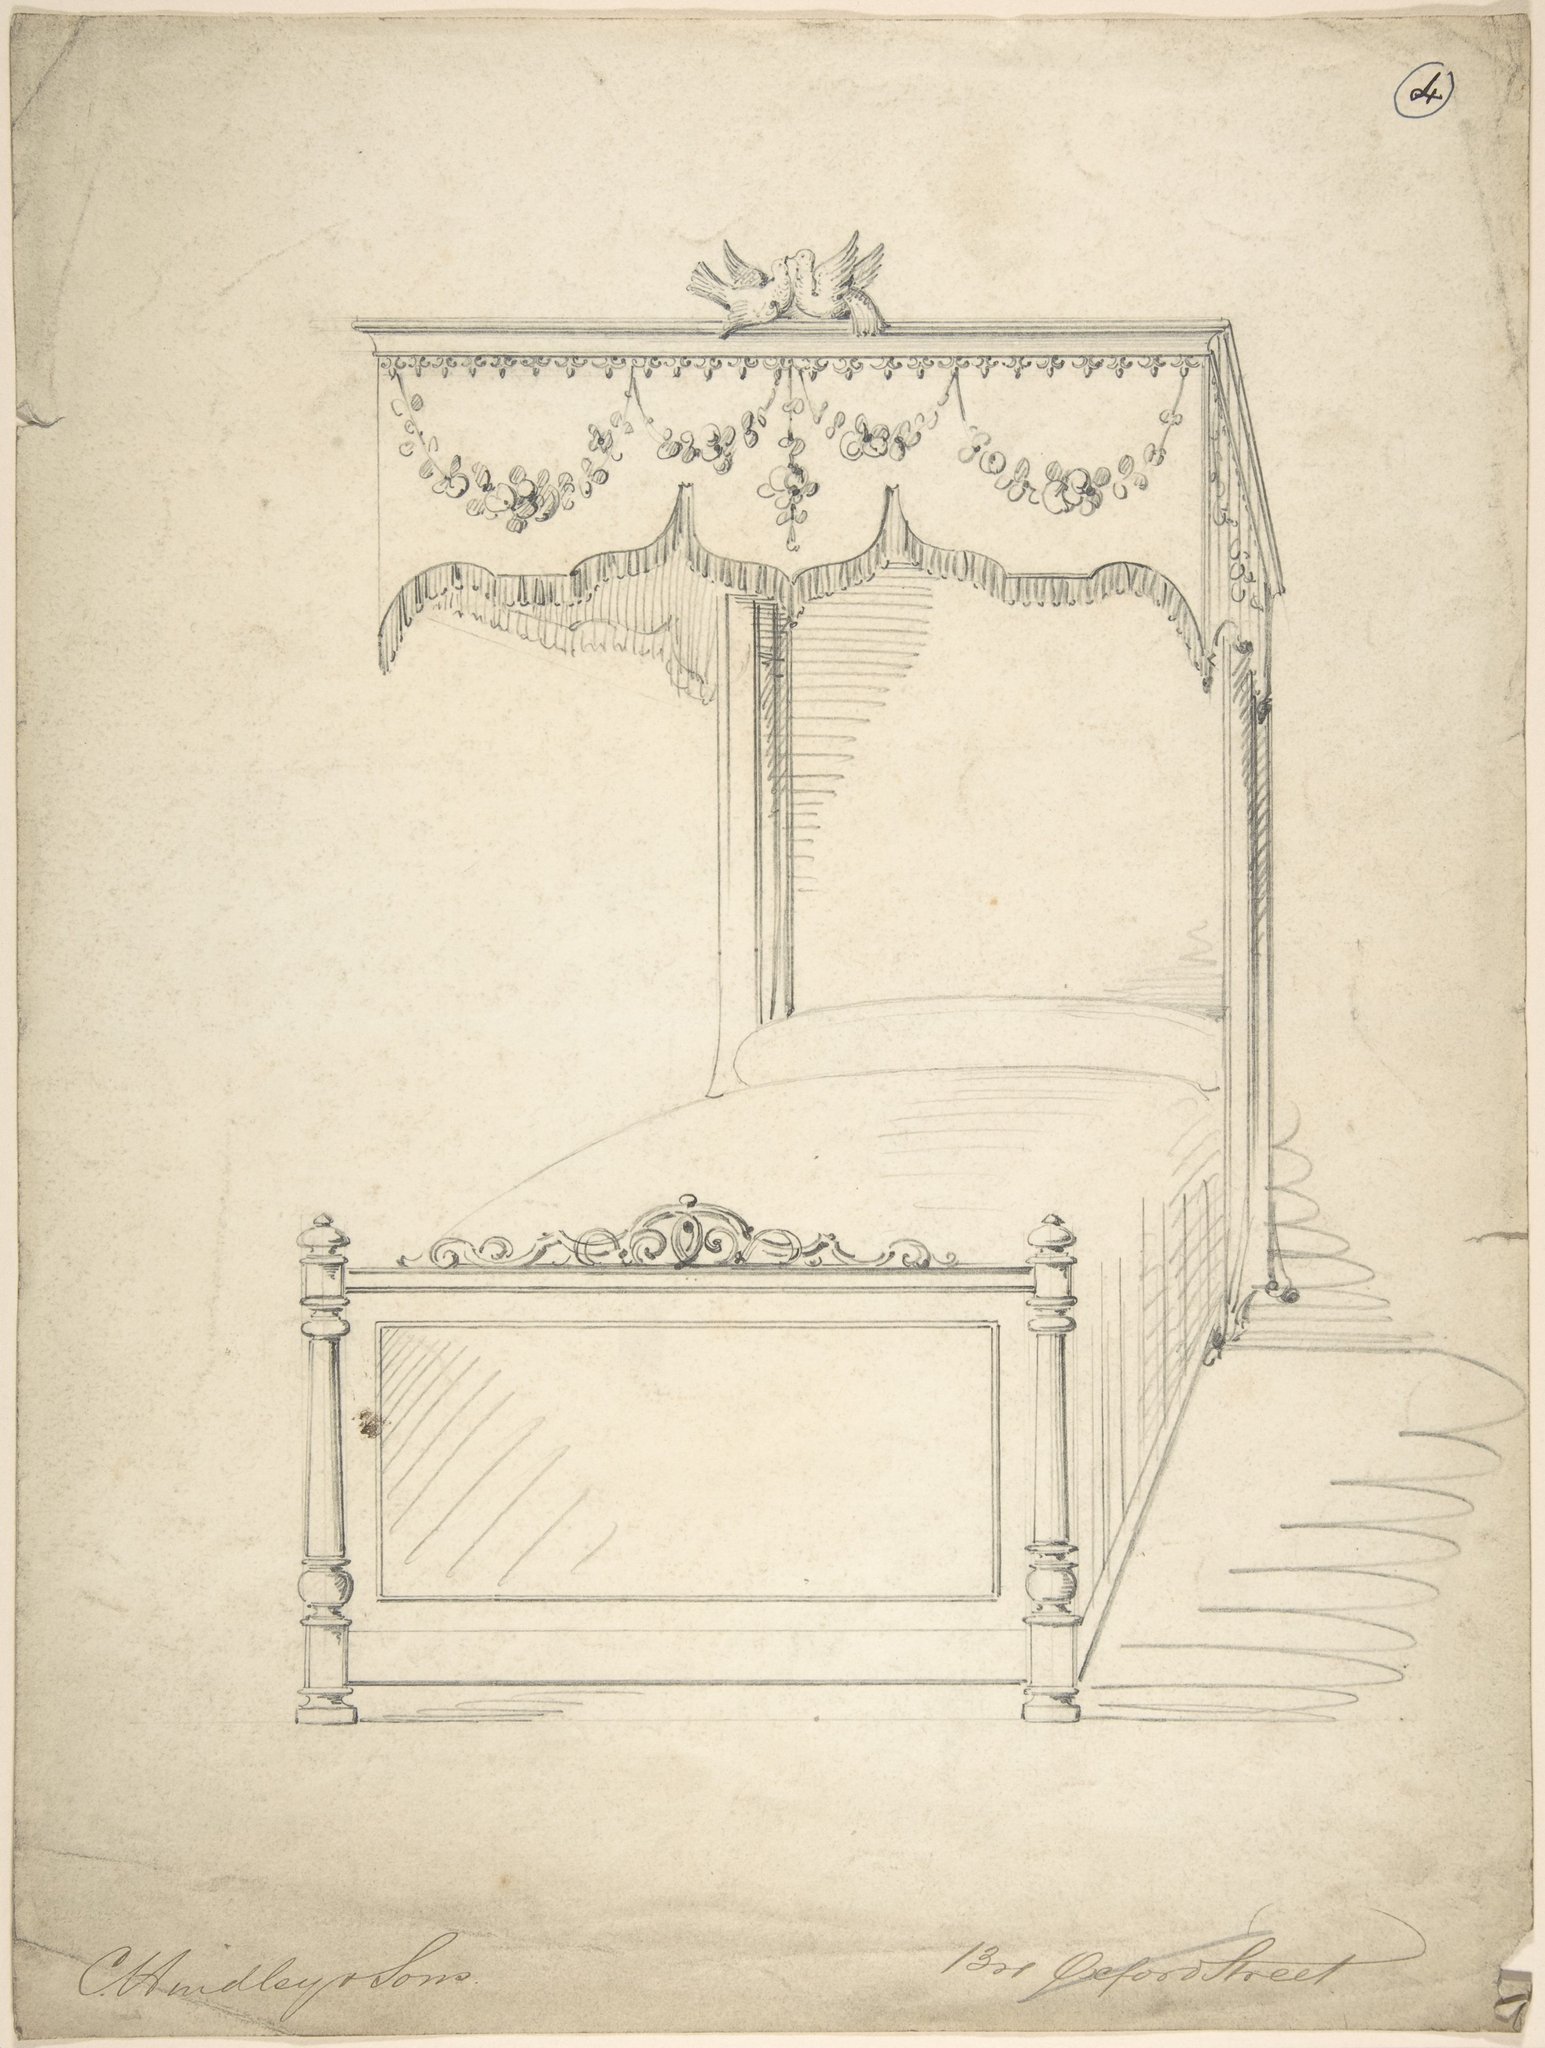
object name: drawing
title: Design for Bed with Canopy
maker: charles hindley and sons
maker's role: artist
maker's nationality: british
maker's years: 1841-1917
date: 1841-1884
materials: graphite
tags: beds